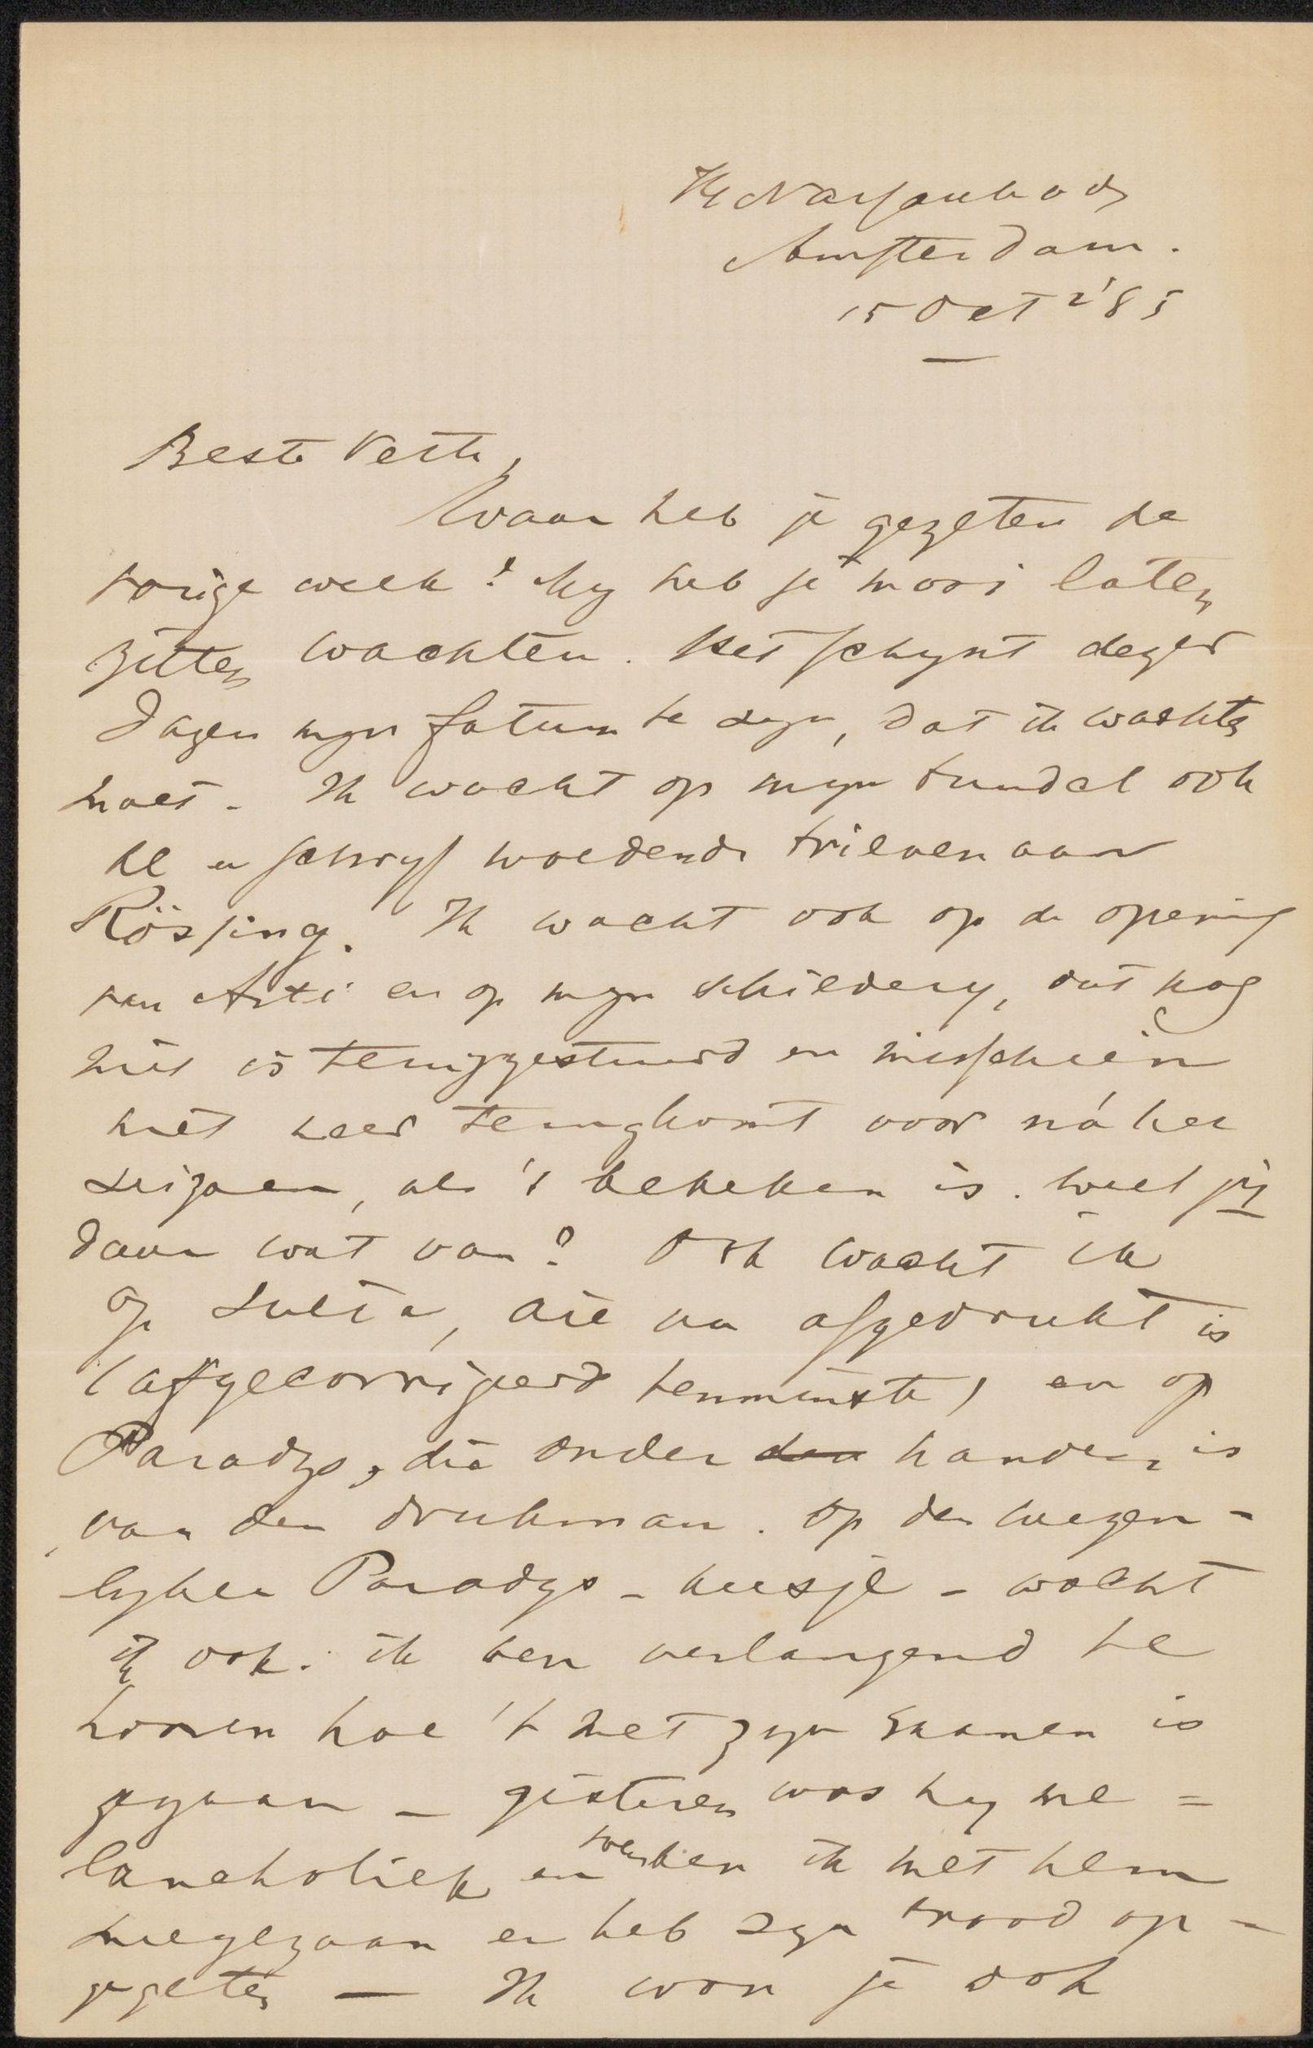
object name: letter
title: Brief aan Jan Veth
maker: albert verwey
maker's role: criticus, dichter, essayist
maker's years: 1865-1937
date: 1885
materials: ink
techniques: pen, writing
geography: amsterdam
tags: dordrecht, painter, print maker, draughtsman, designer, jan veth, publisher, adriaan rössing, amsterdam, frank van der goes, haarlem, frederik van eeden, literature ~ arts, painting (including book-illumination, miniature-painting)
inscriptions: collector's mark: ‘RPK’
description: Opgenomen in: Verwey, Albert, Margaretha H. Schenkeveld, Rein van der Wiel: Briefwisseling 1 juli 1885 tot 15 december 1888, Amsterdam: EM. Querido's Uitgeverij B.V., 1993, p. 65-66.